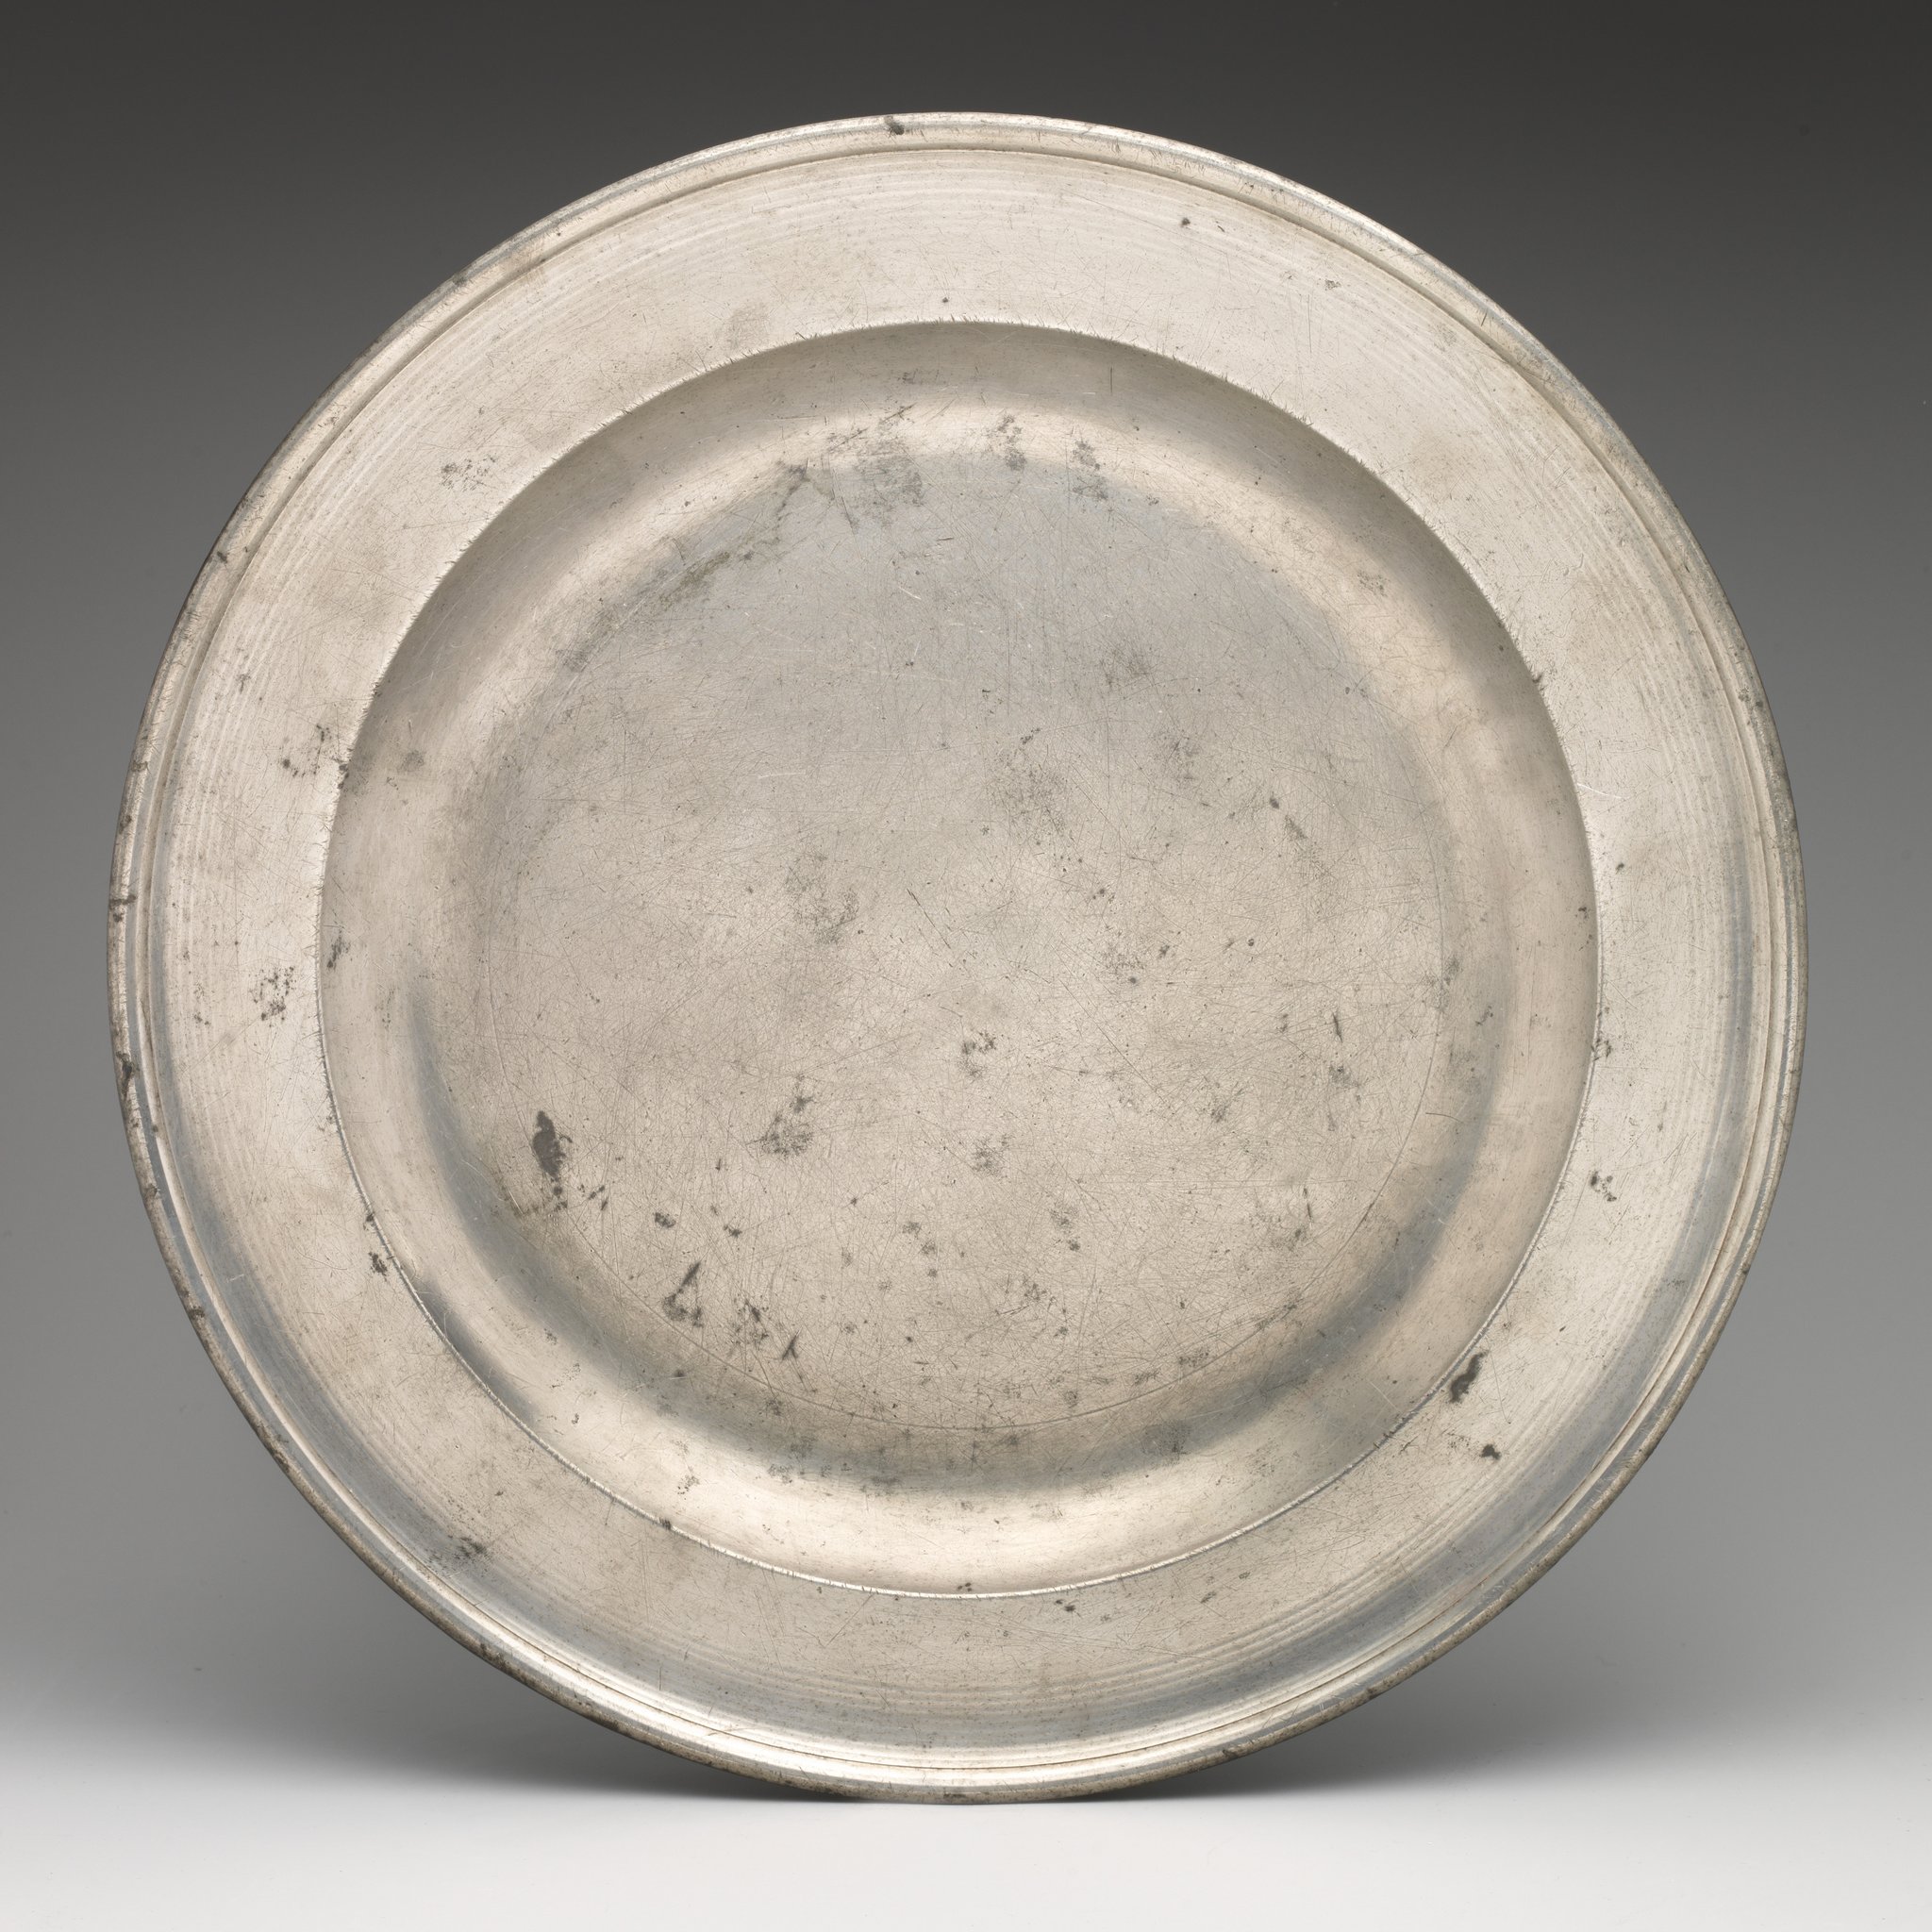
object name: plate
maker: samuel ellis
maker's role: maker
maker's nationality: british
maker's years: 1673-1773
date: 1751-1800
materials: pewter